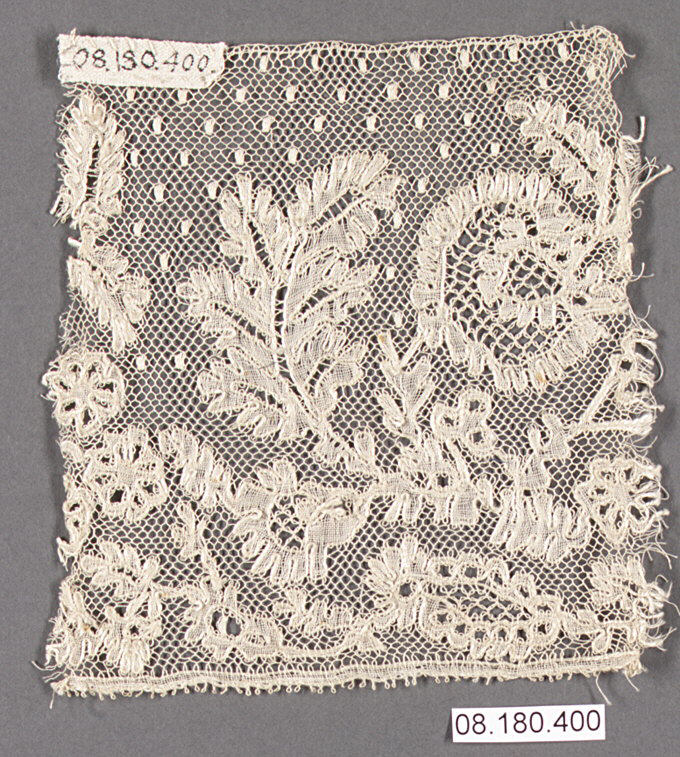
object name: fragment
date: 1801-1833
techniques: lace